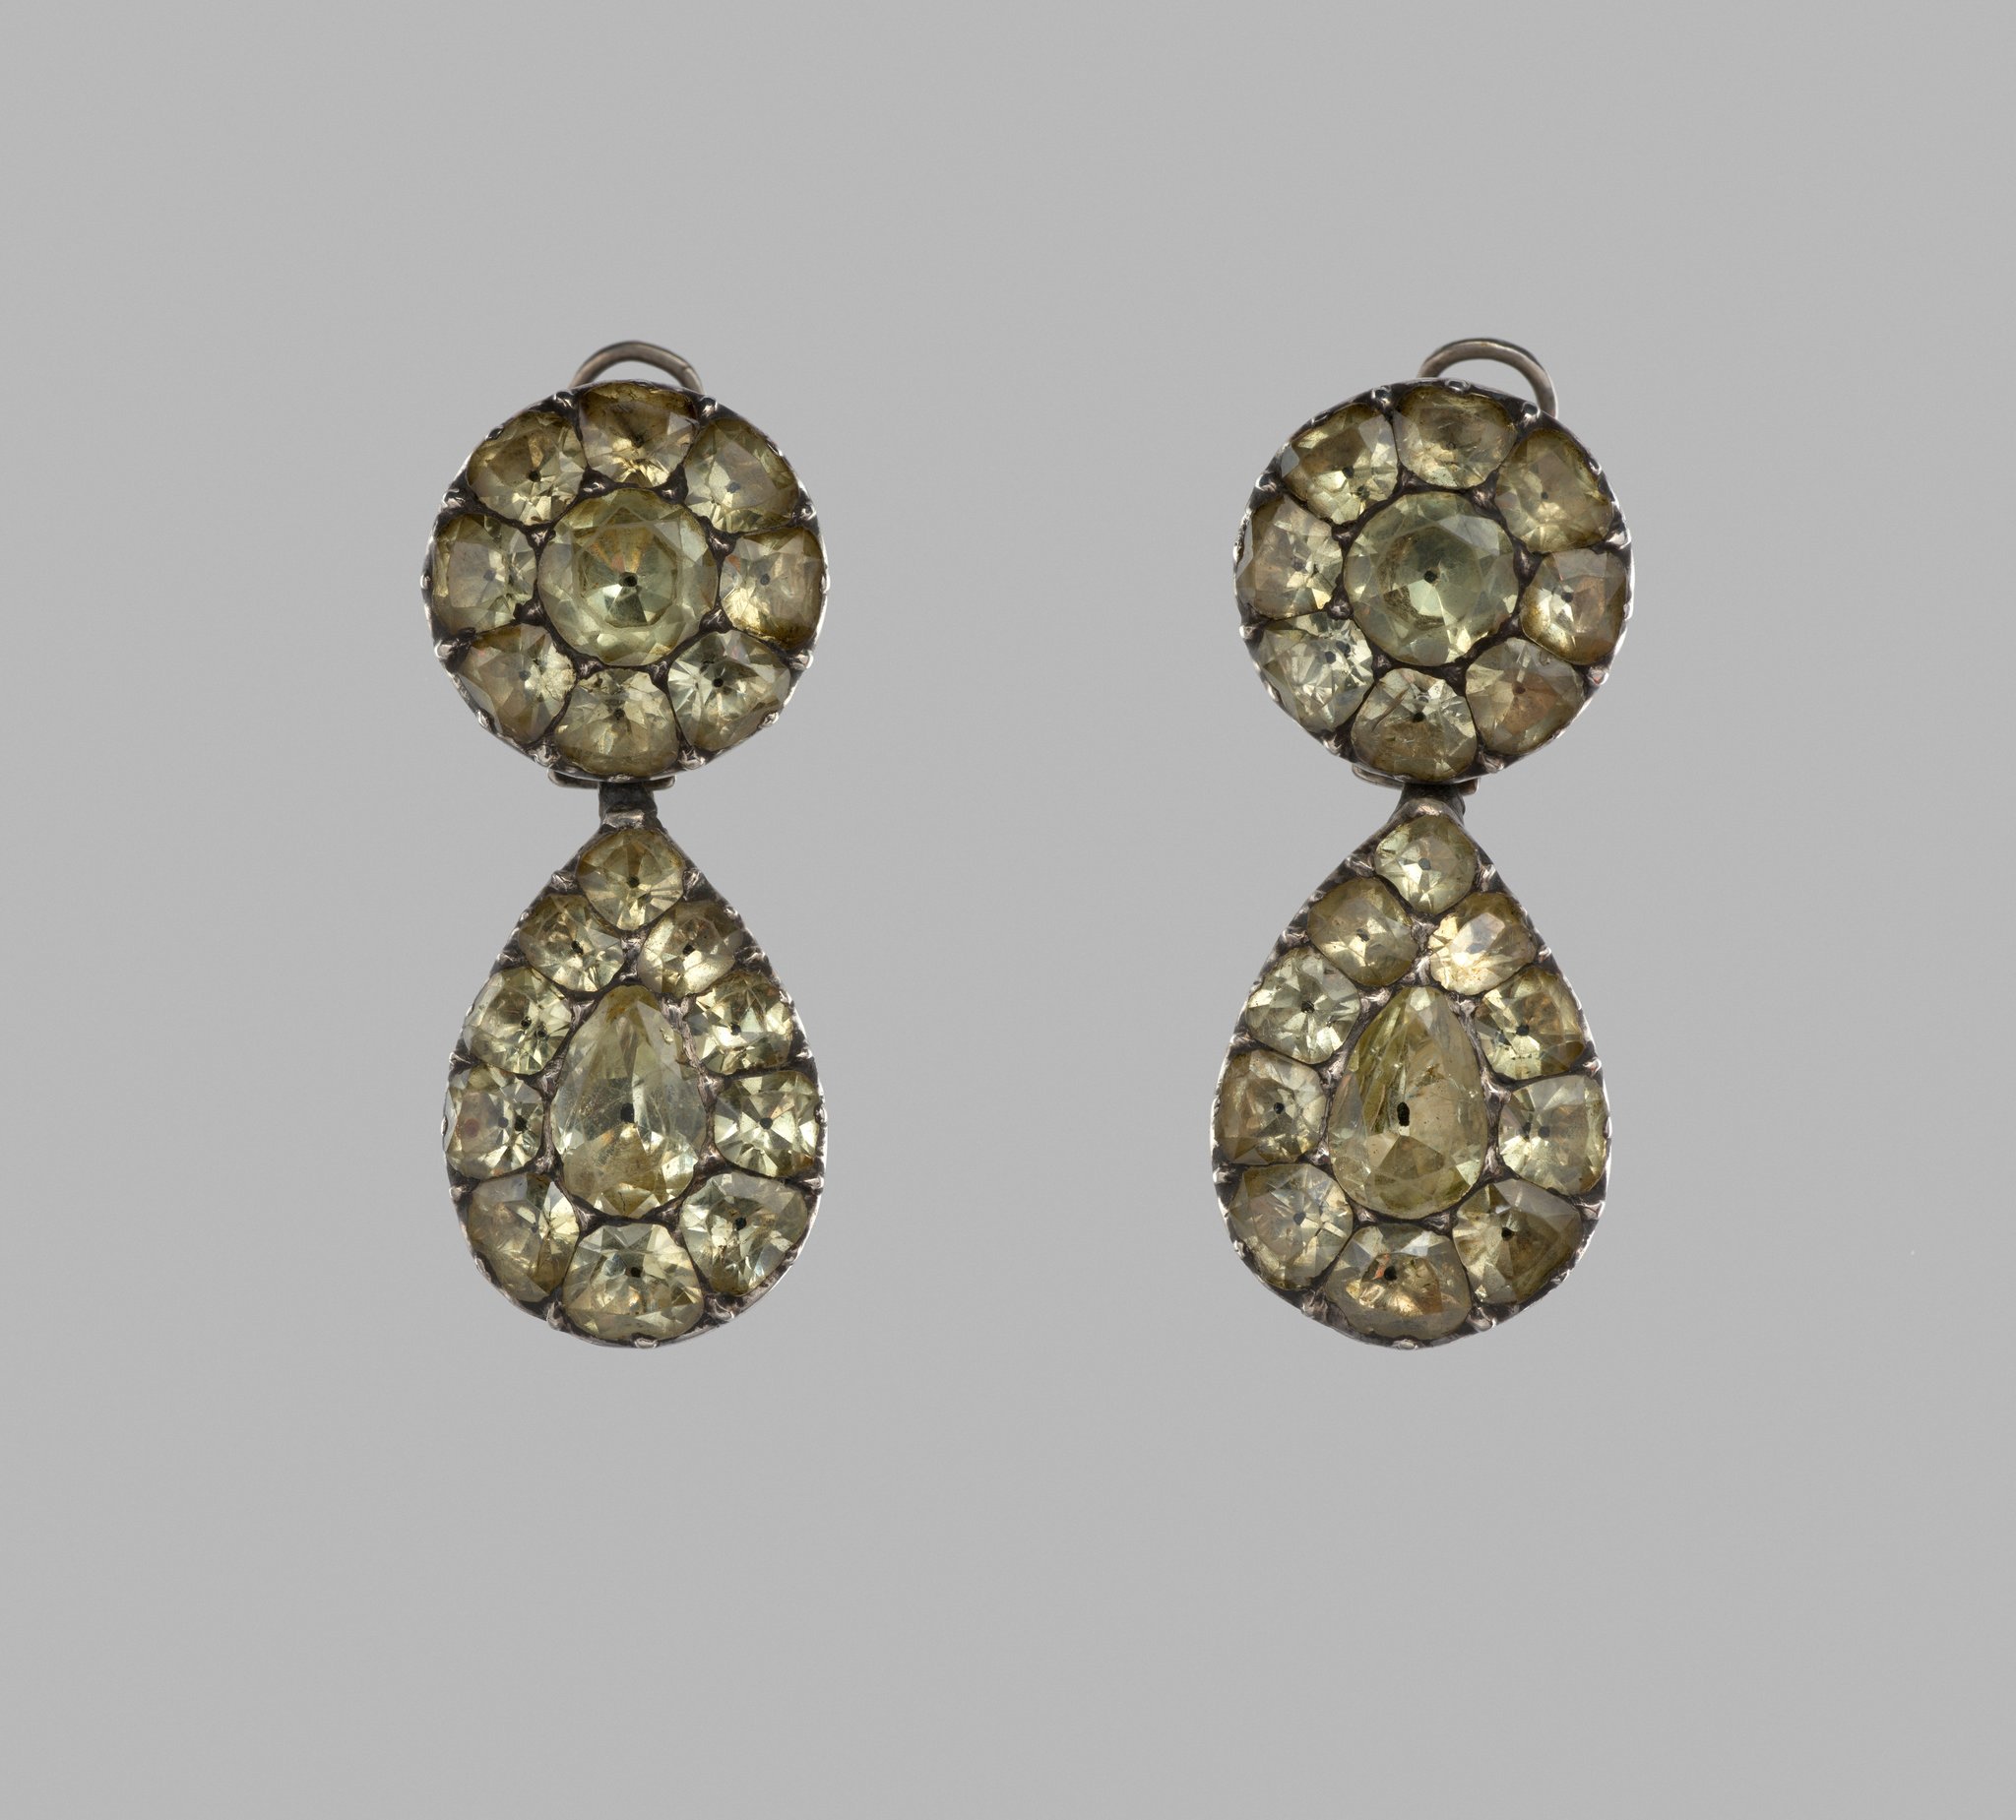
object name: earring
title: Pair of earrings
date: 1701-1800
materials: diamond, paste, silver